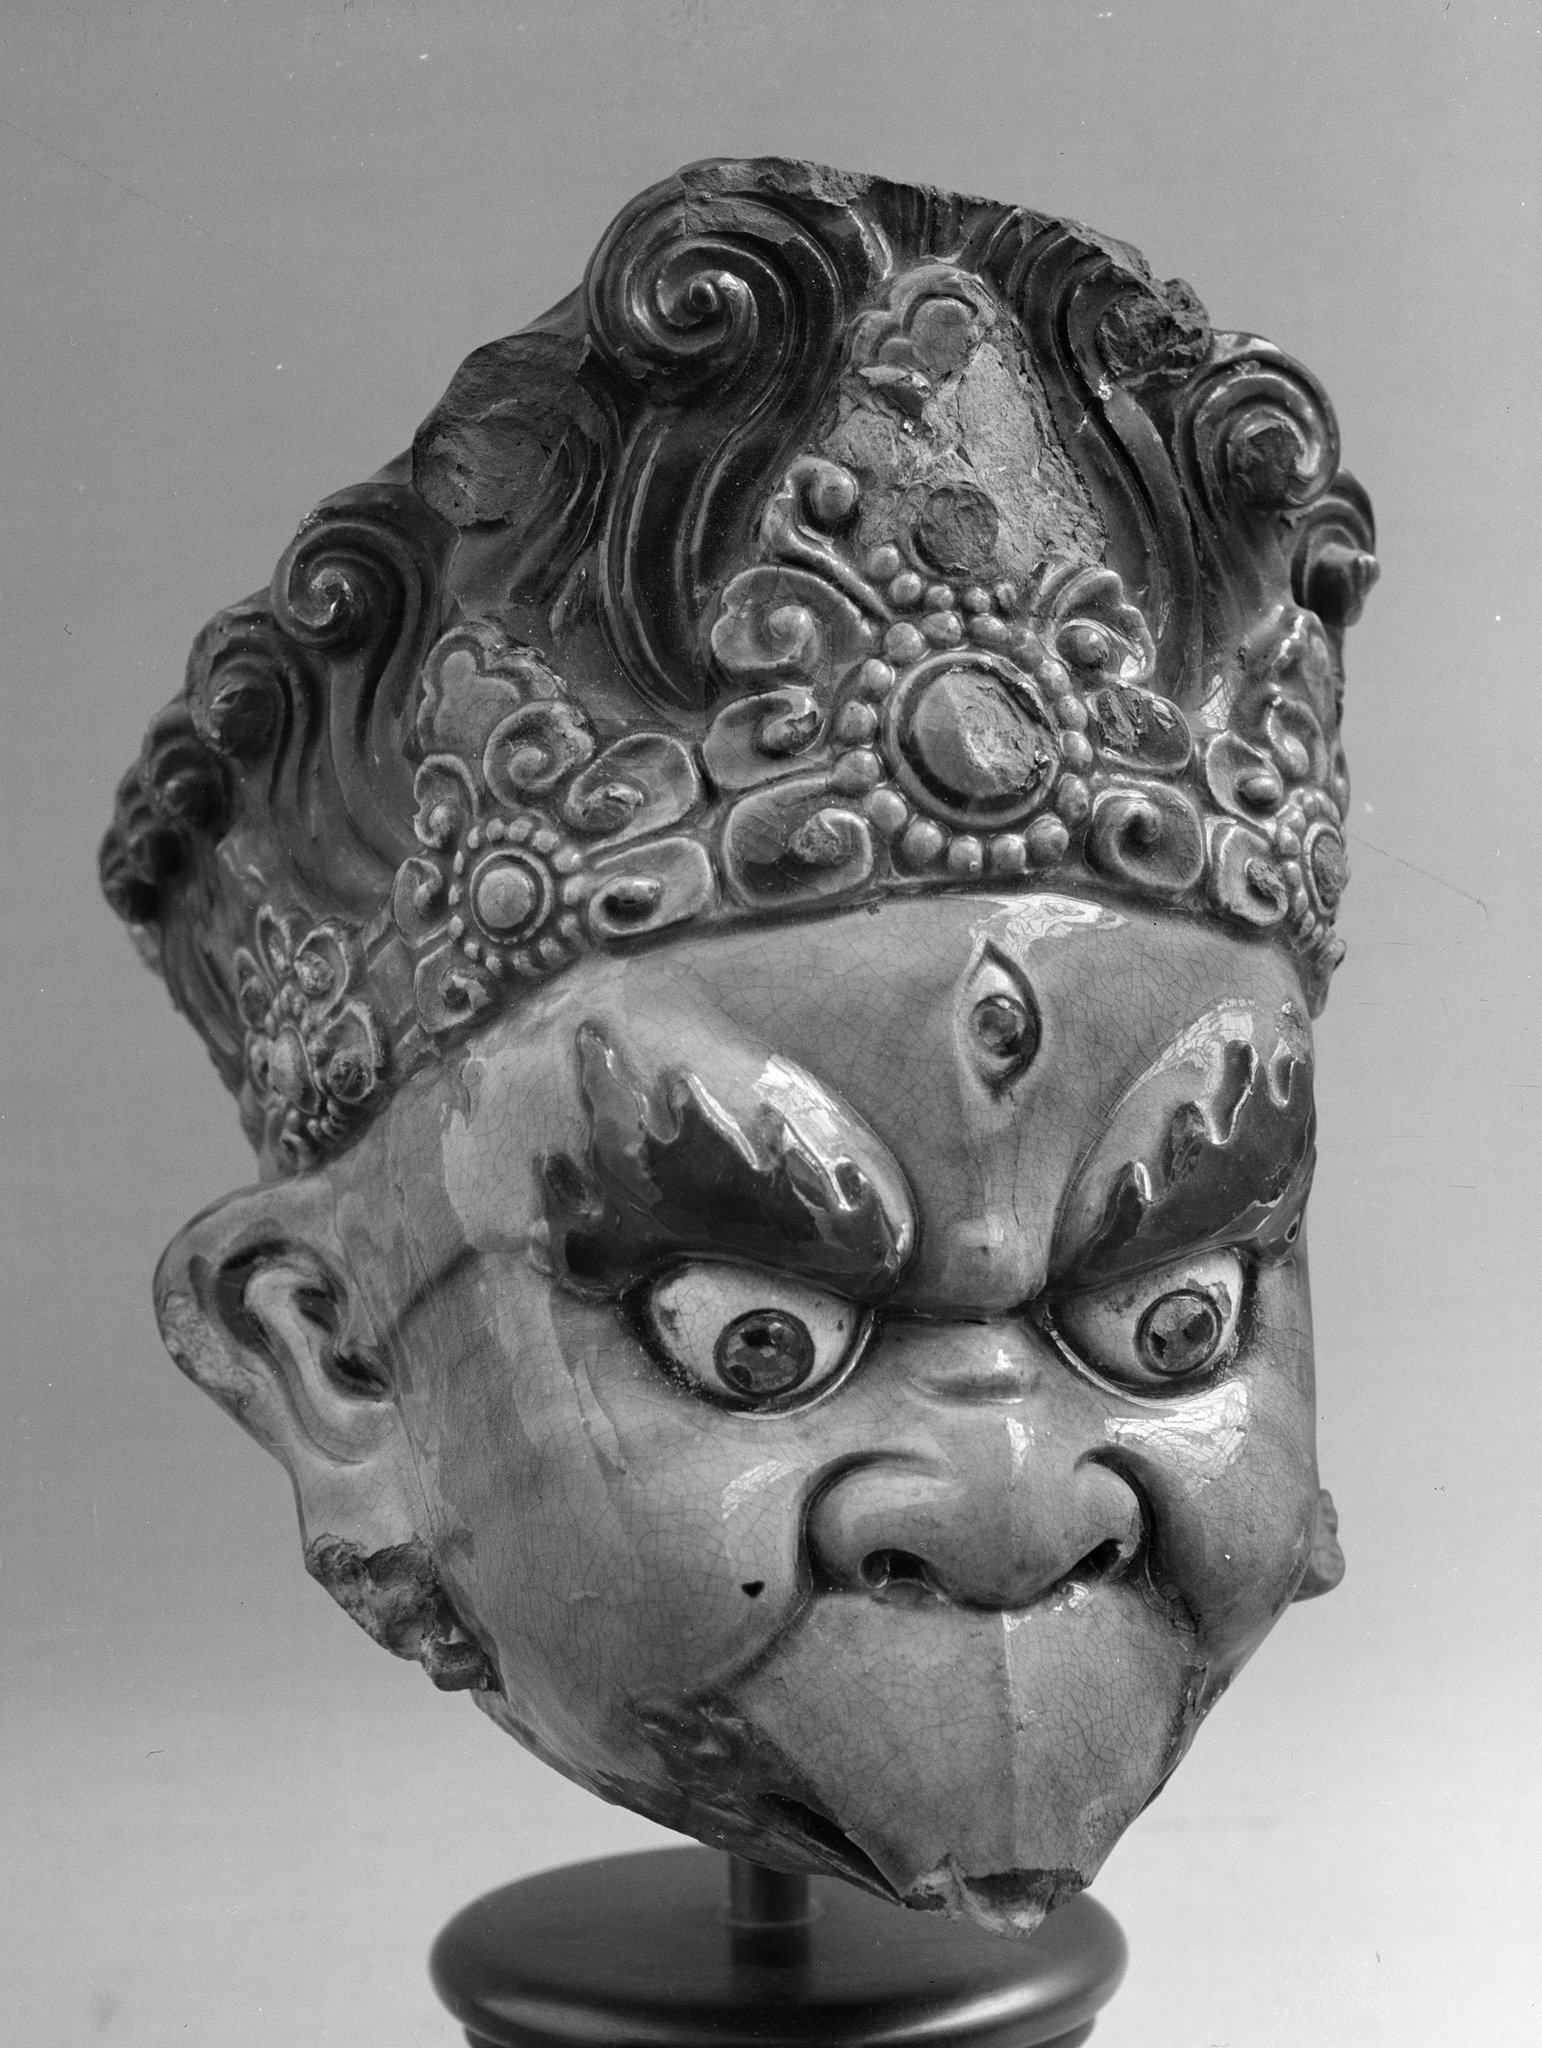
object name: ornament architecture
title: Architectural ornament: head of Garuda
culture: chinese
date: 1401-1500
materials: glaze, stoneware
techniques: polychrome